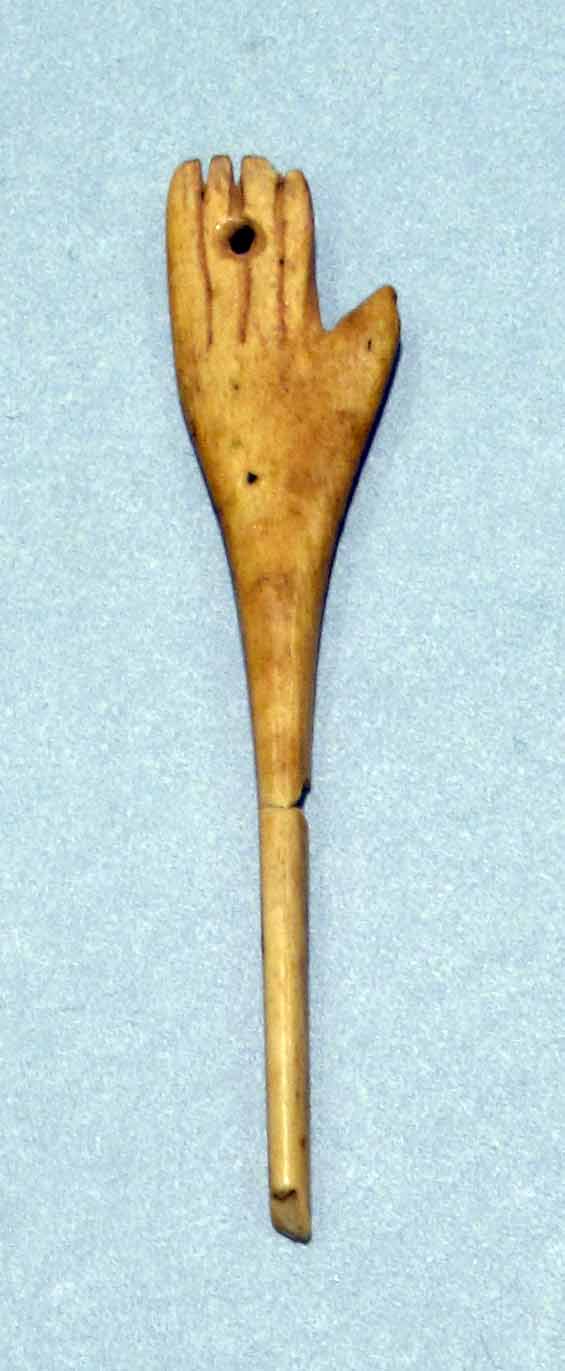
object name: cosmetic tool, hand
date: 1550-1295 BCE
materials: ivory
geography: egypt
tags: hands